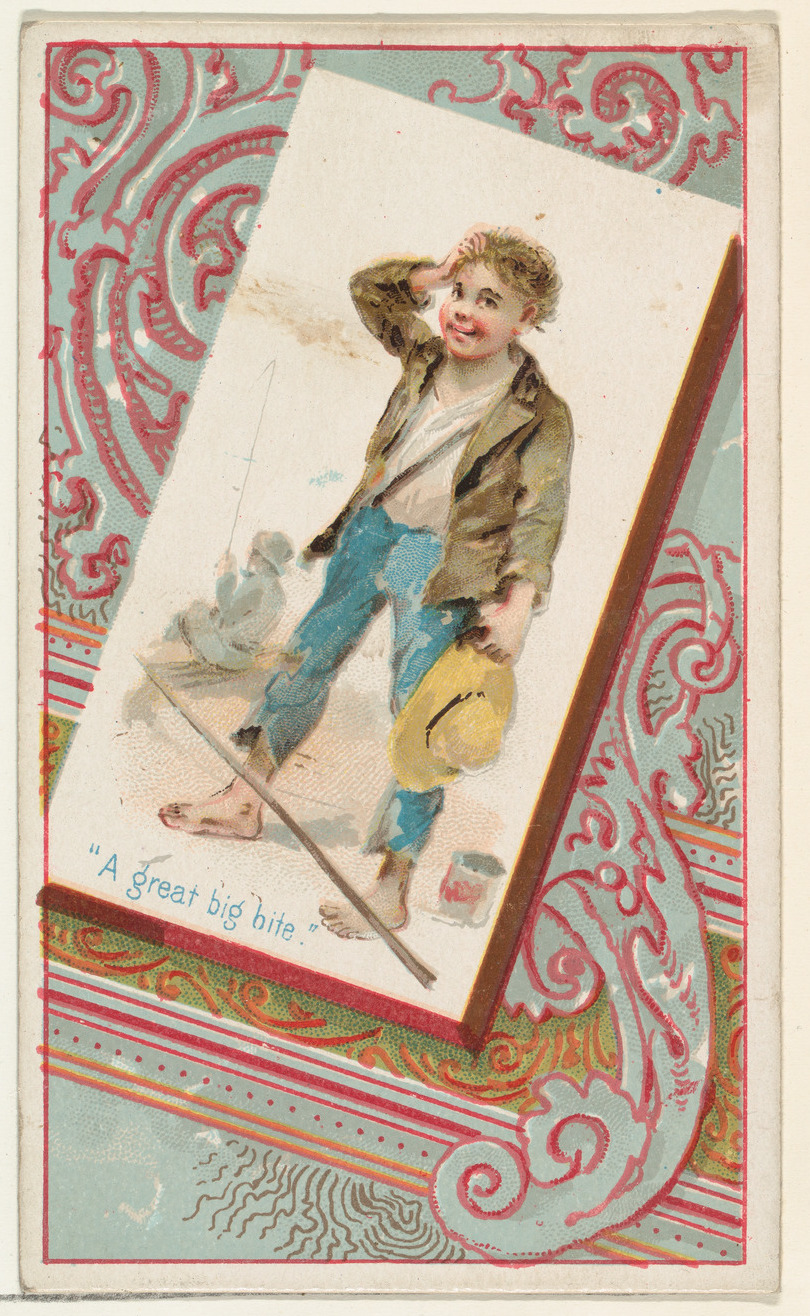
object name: print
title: "A great big bite," from the Terrors of America set (N136) issued by Duke Sons & Co. to promote Honest Long Cut Tobacco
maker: w. duke, sons & co.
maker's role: publisher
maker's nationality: american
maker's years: 1870-1920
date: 1888-1889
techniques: color lithograph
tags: boys